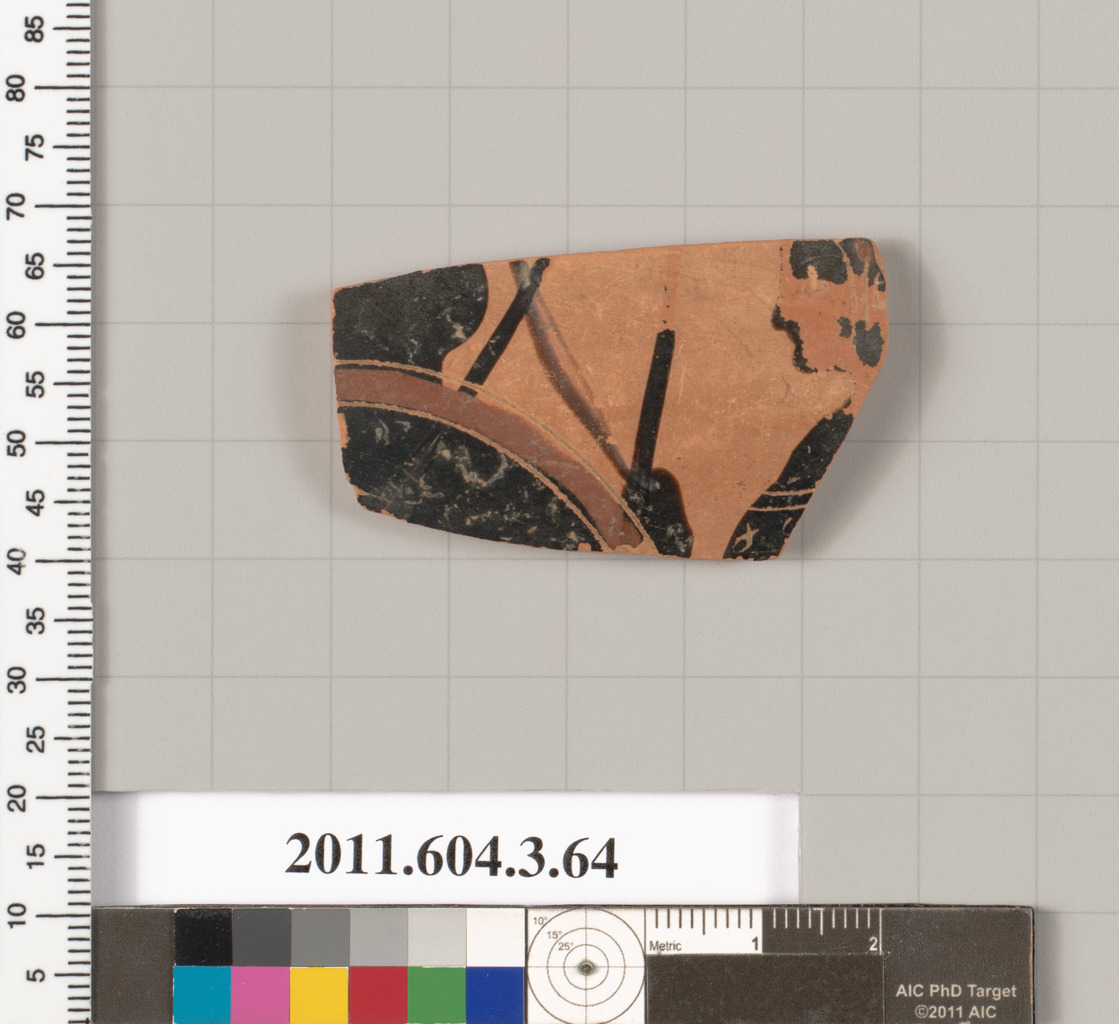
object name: amphora fragment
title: Terracotta fragment of an amphora (jar)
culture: greek, attic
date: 534-468 BCE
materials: terracotta